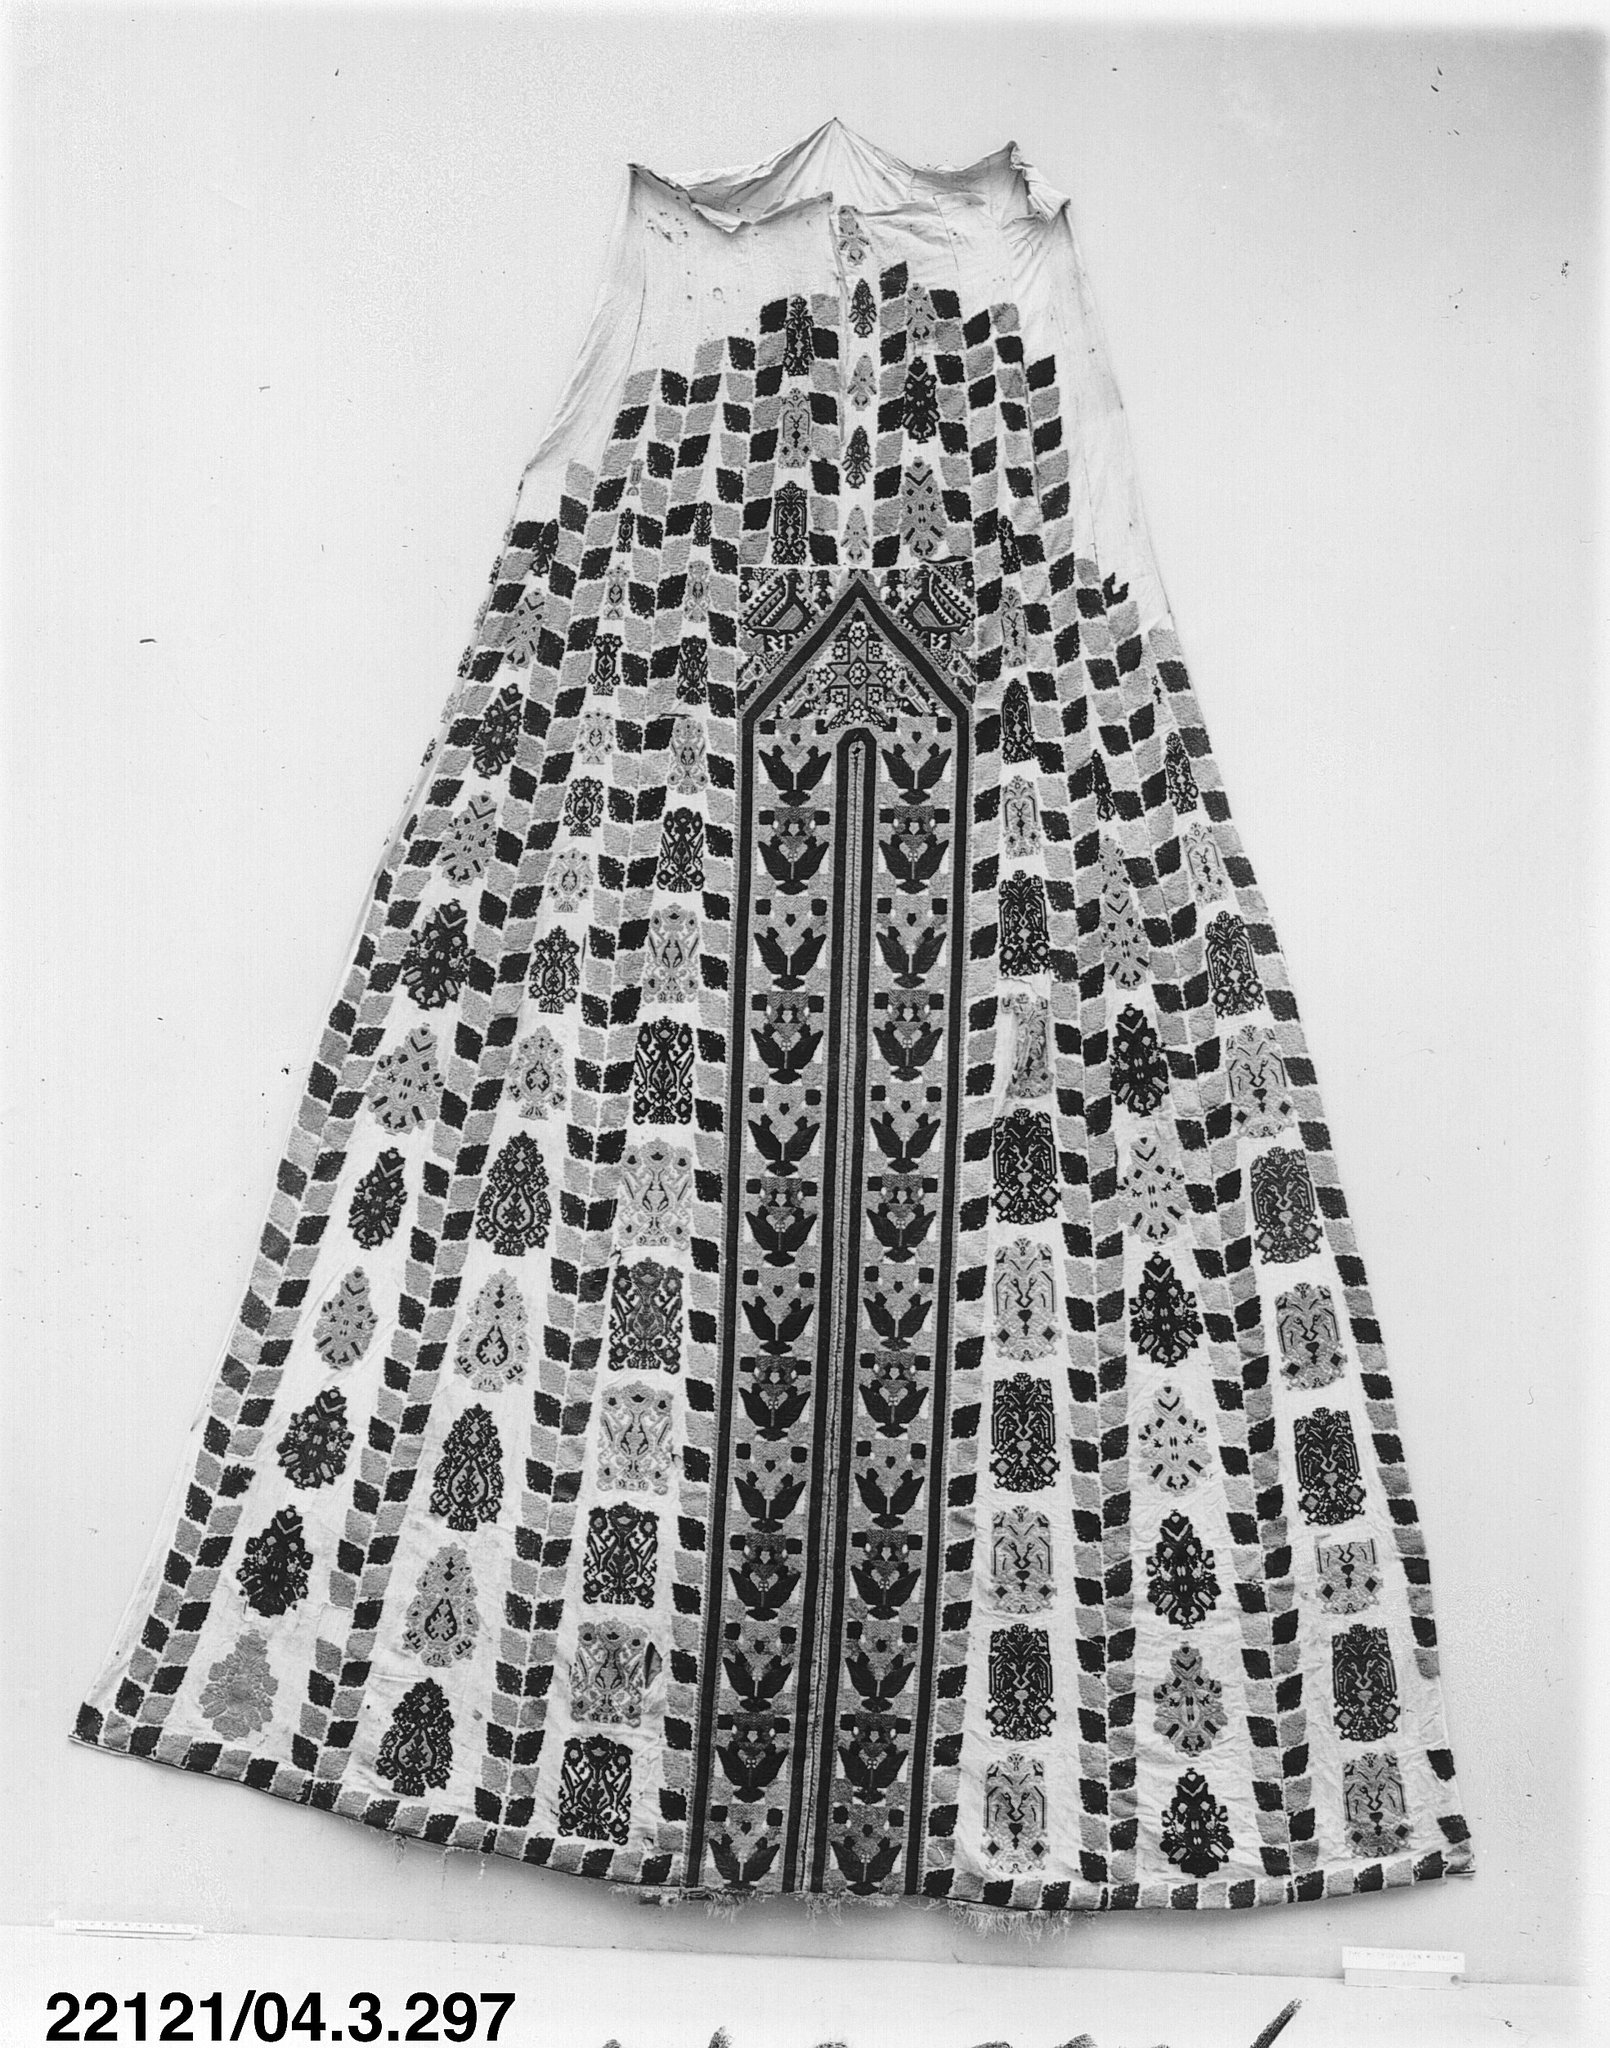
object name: bed tent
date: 1701-1800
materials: linen, silk